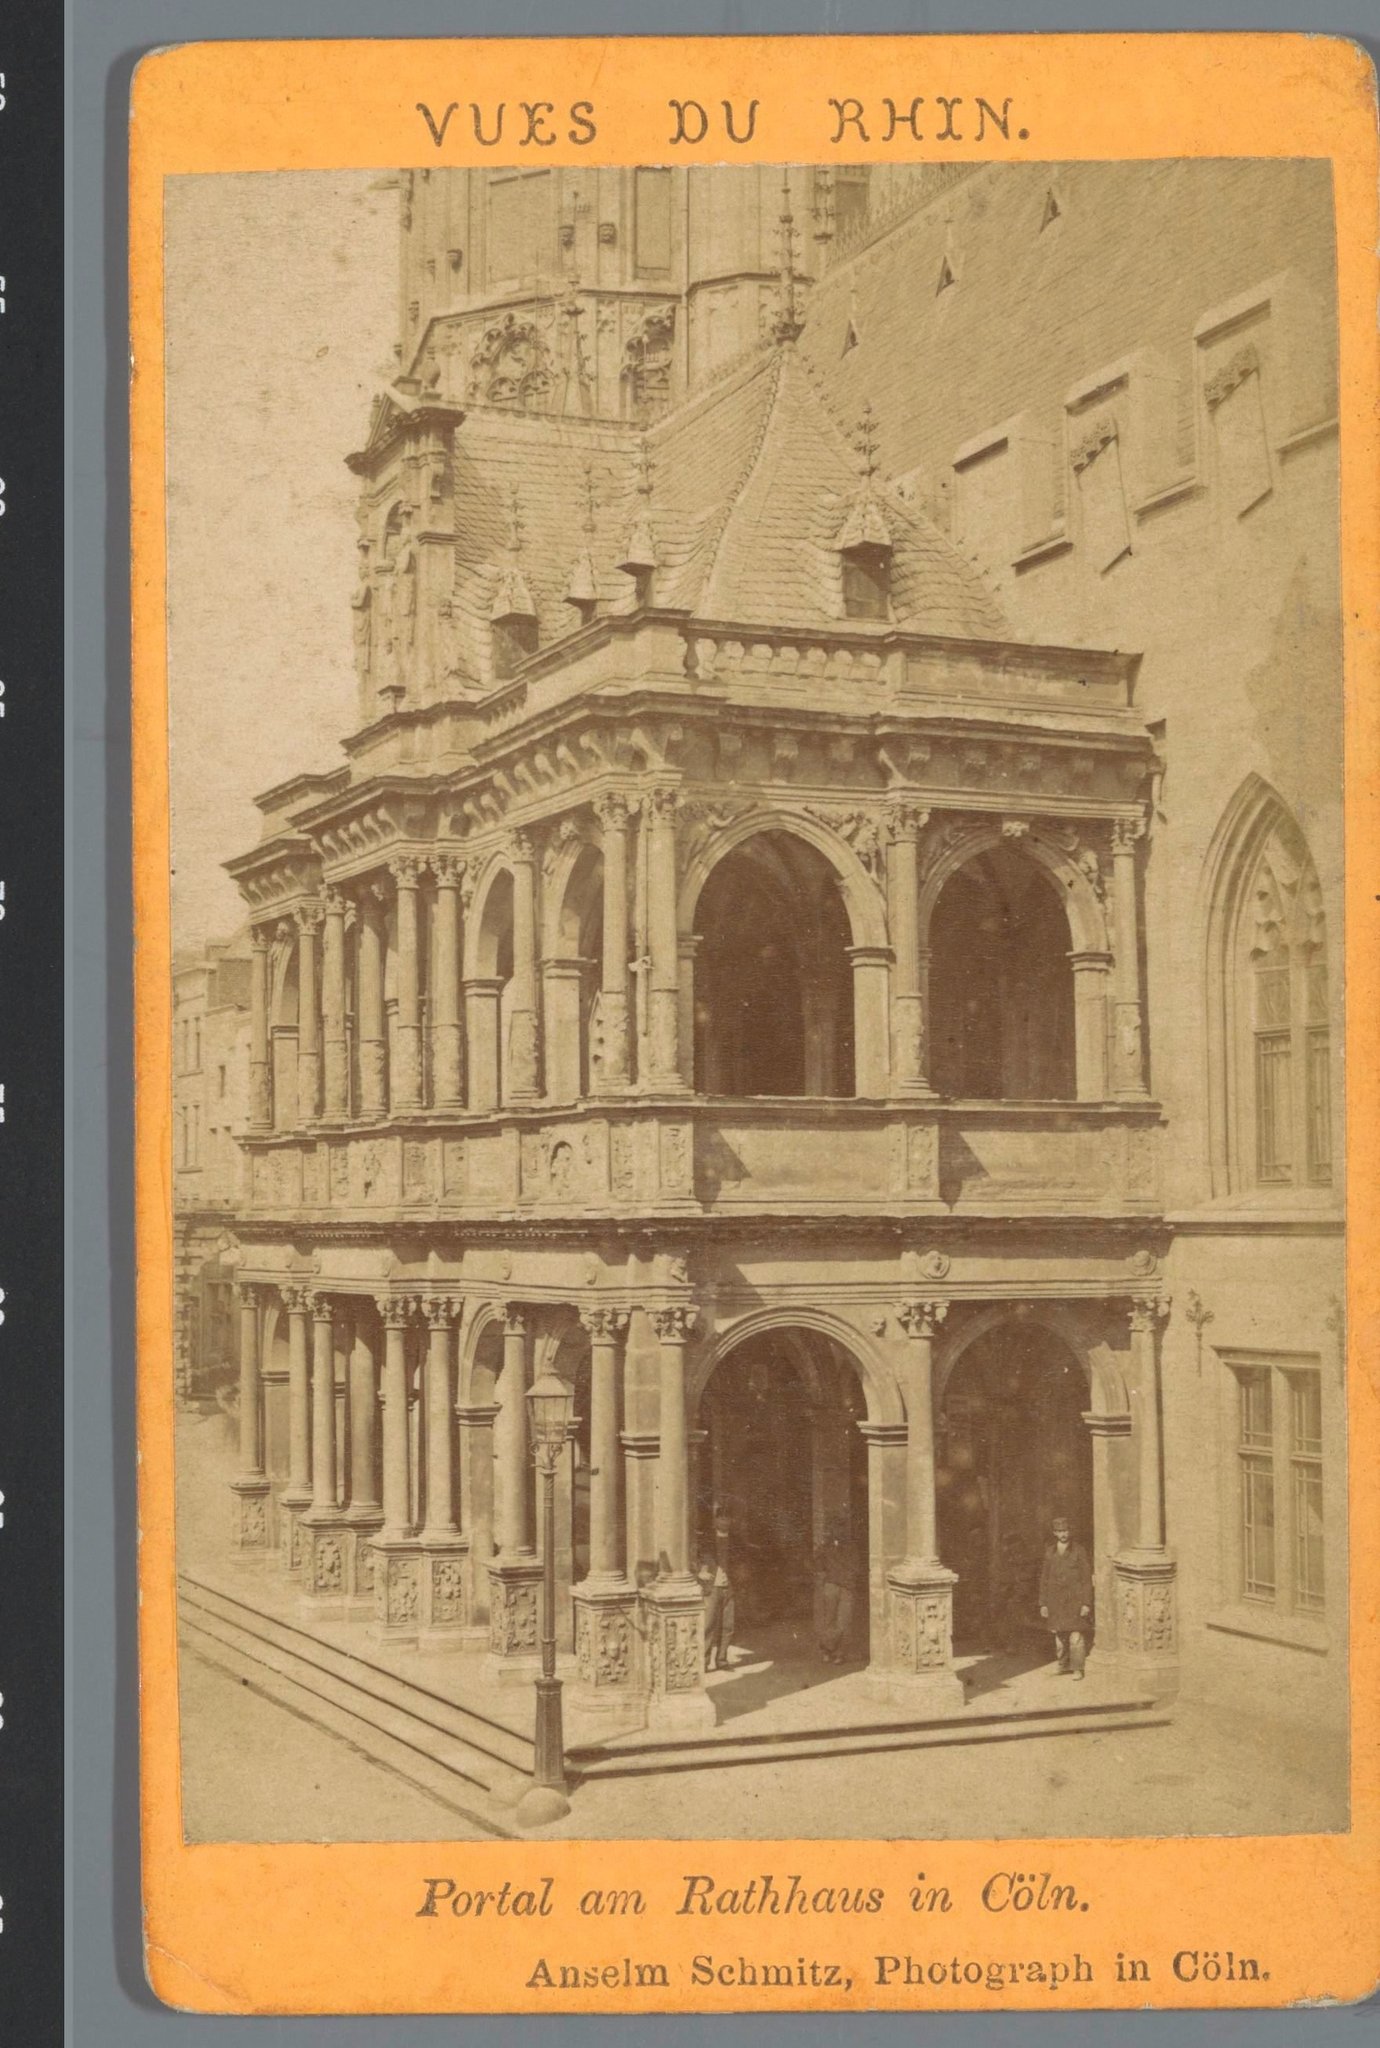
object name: photograph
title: Vues du Rhin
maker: anselm schmitz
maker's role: publisher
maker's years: 1831-1903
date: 1869-1903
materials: cardboard, paper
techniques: albumen print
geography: cologne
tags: townhall, exterior ~ representation of a building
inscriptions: inscription: ‘1569-1571’